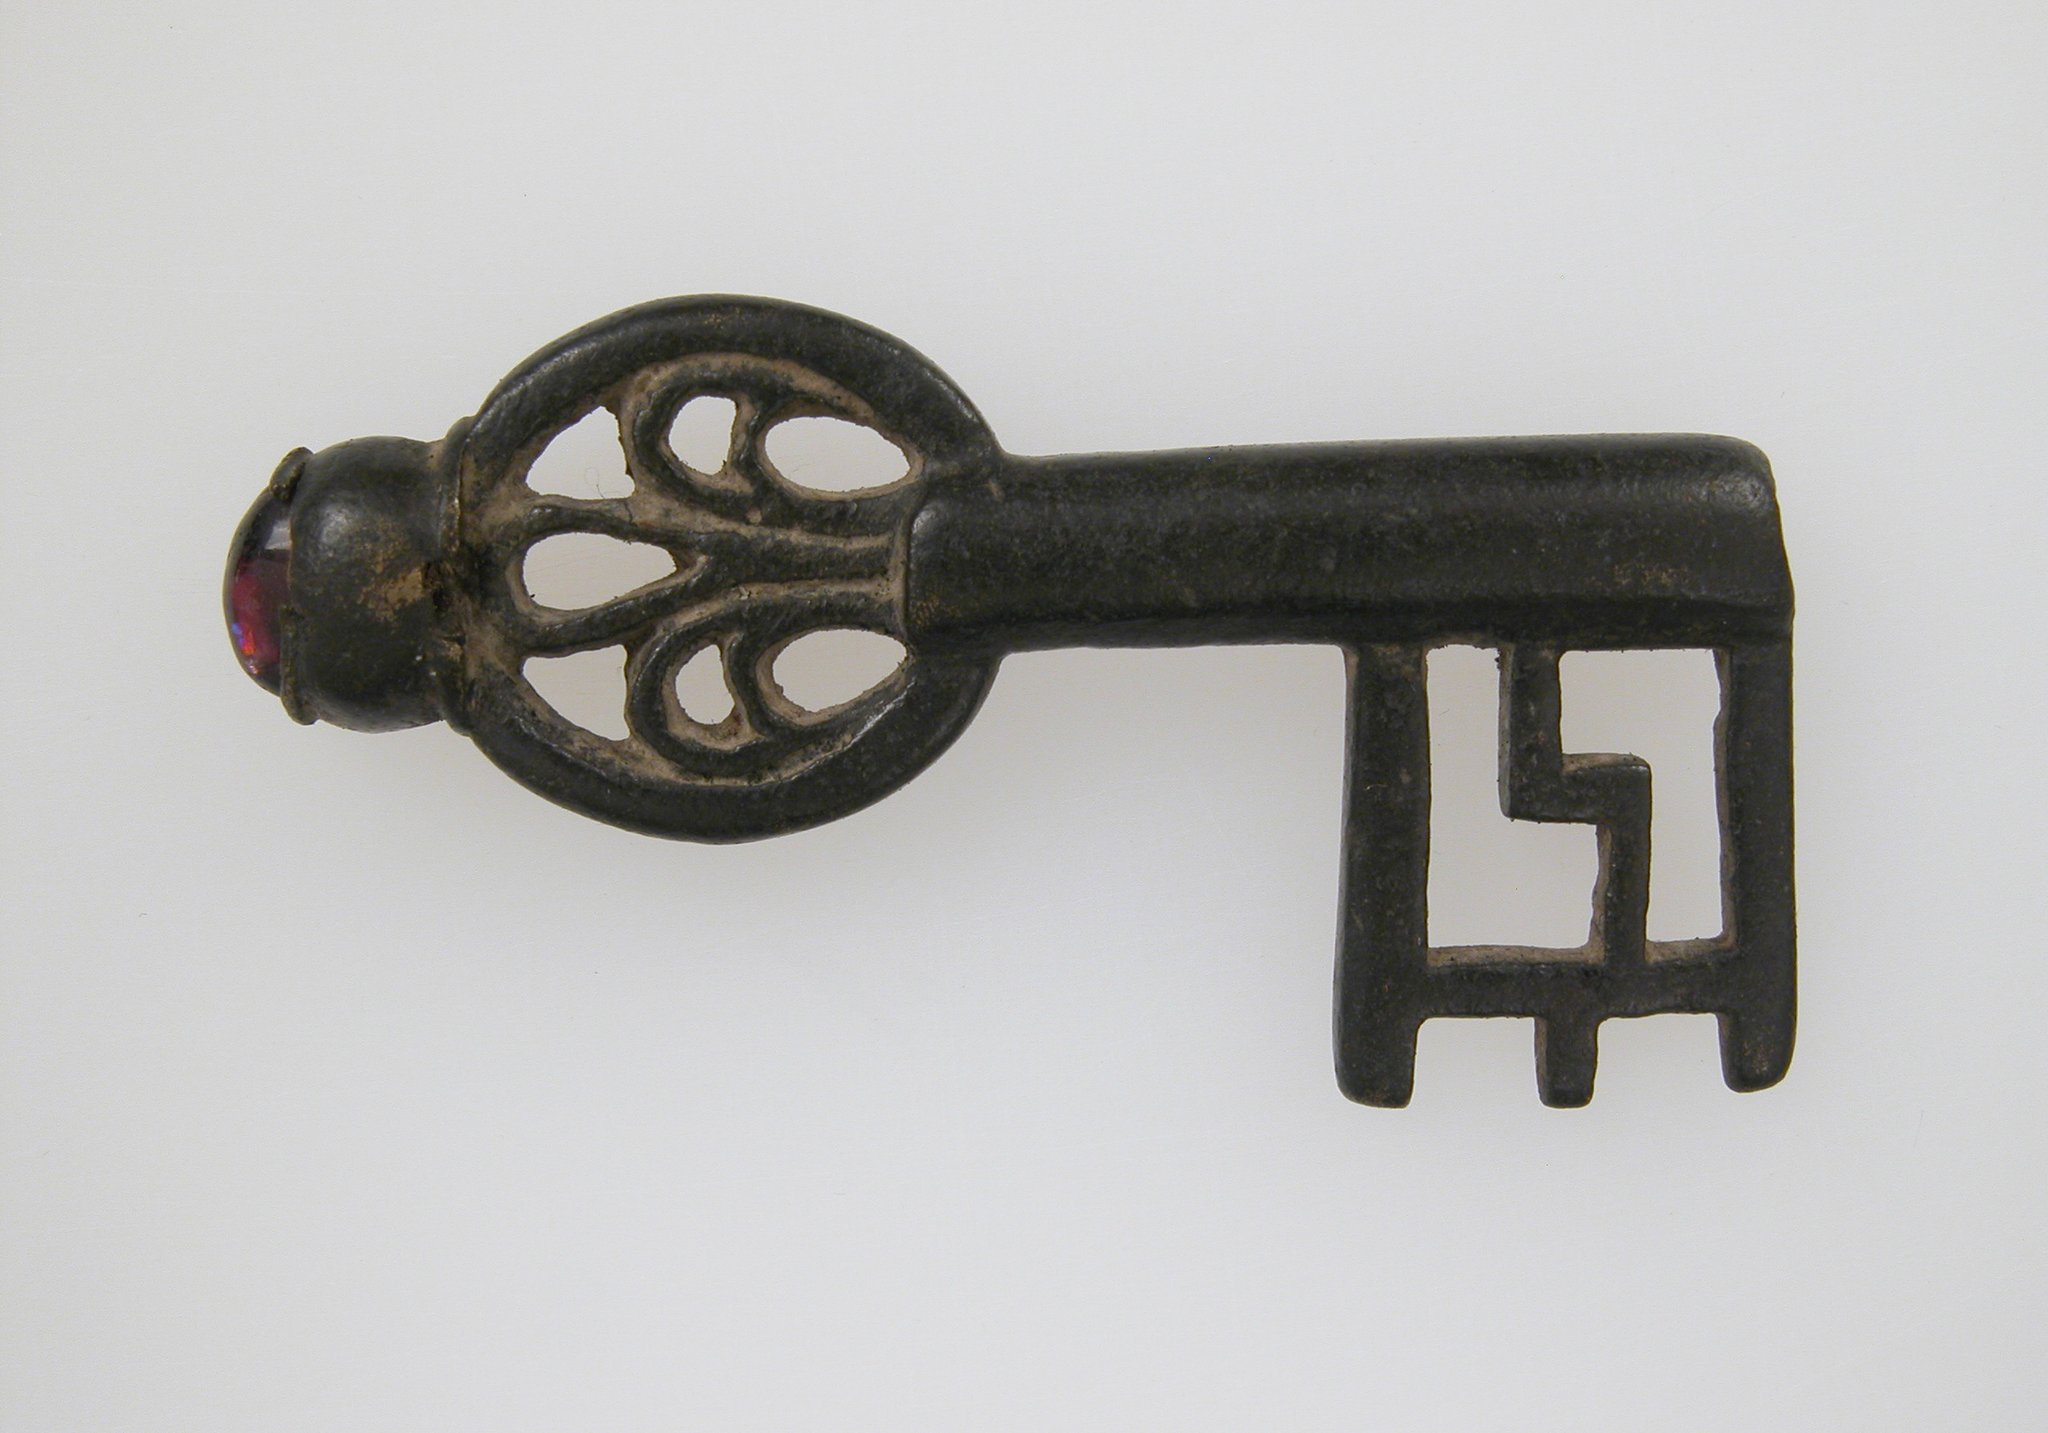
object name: key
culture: french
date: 1401-1500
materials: gemstone, copper alloy